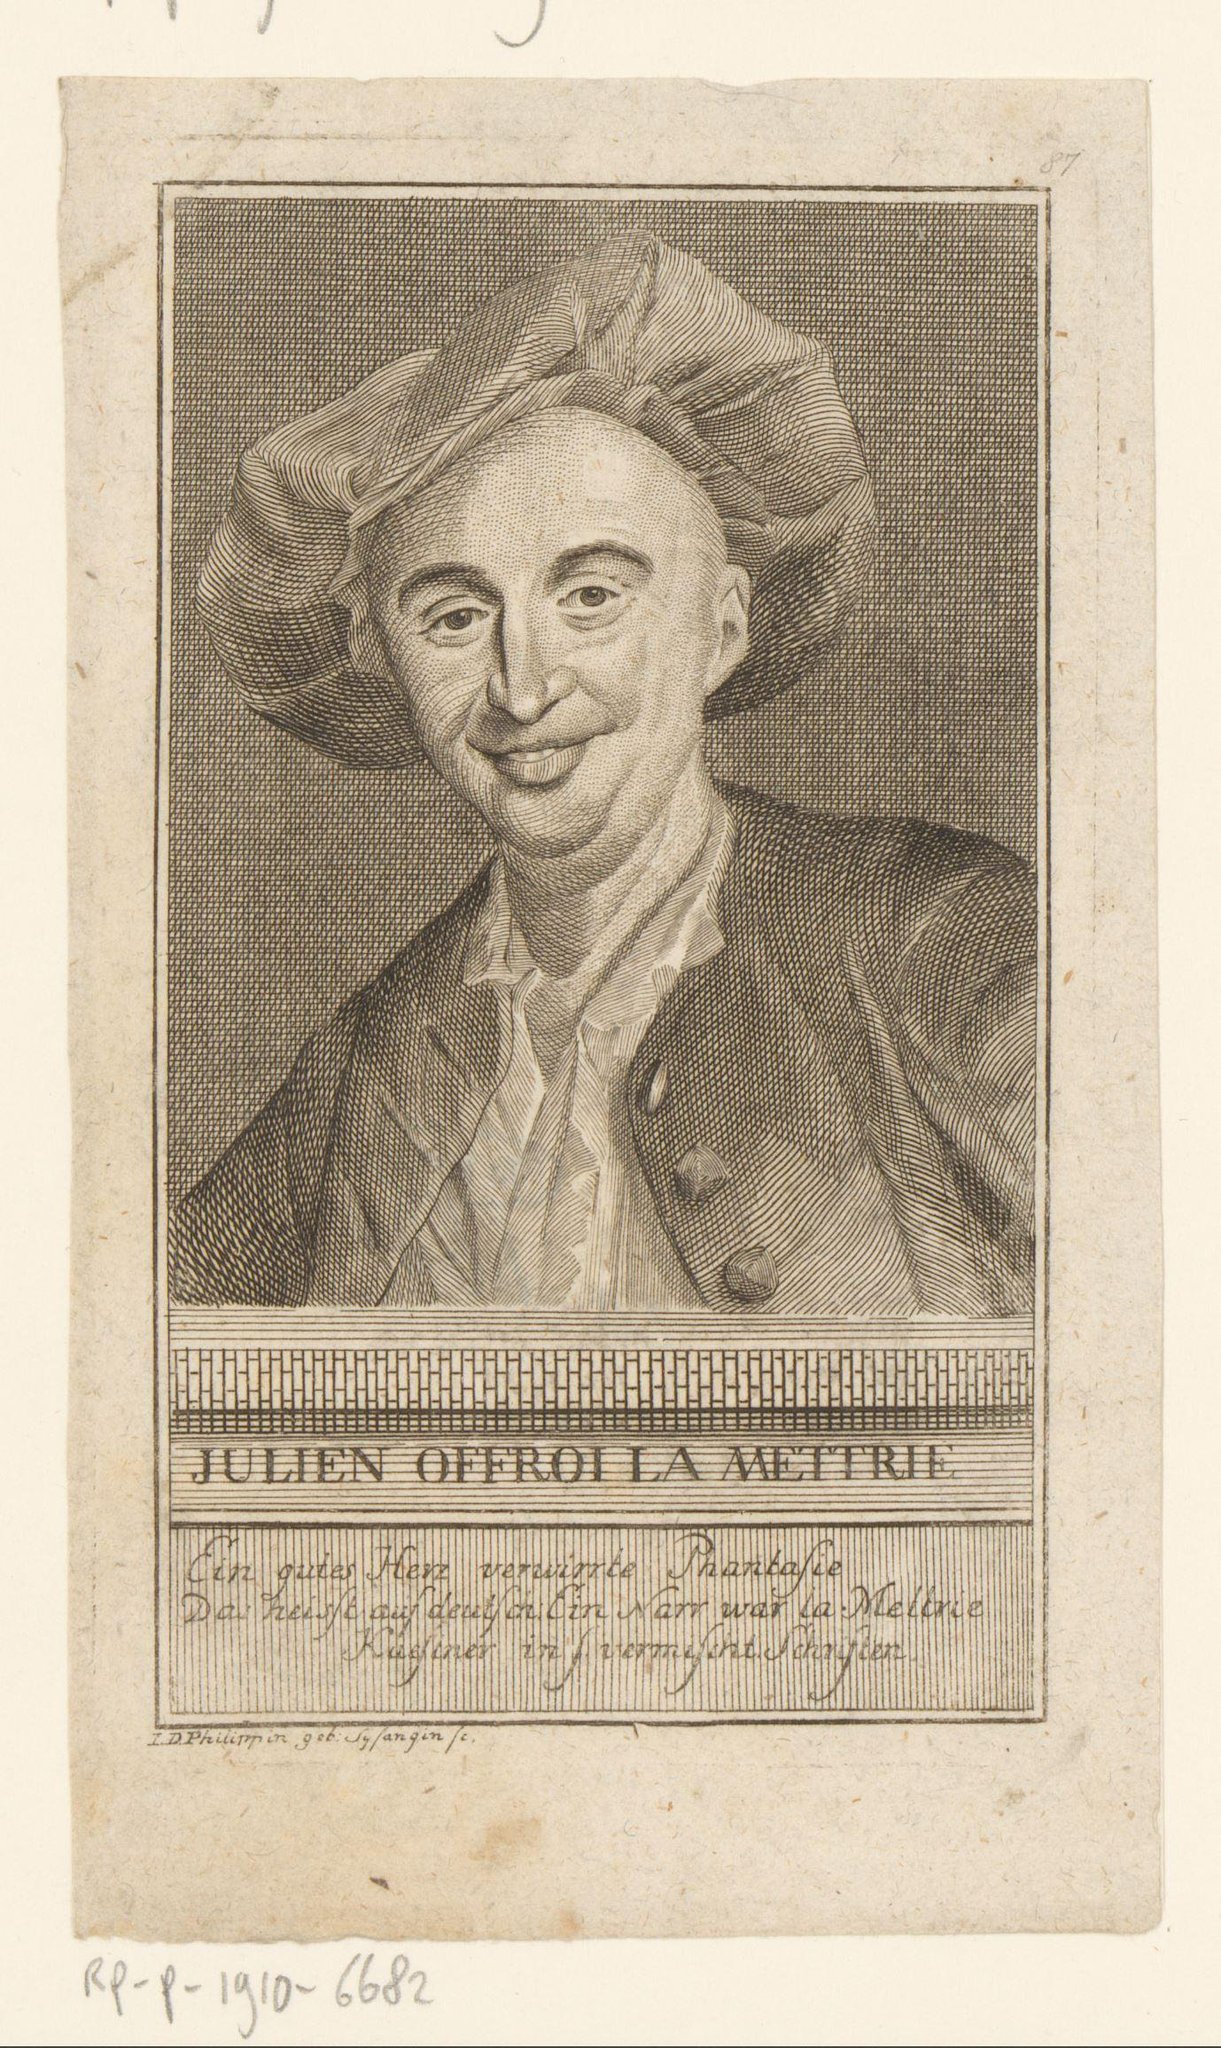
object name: print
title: Portret van Julien Offray de la Mettrie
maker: johanna dorothea sysang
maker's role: print maker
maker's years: 1729-1791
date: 1739-1791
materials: paper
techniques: engraving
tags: berlin, historical persons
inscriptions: collector's mark: Lugt 2228, number: ‘87’